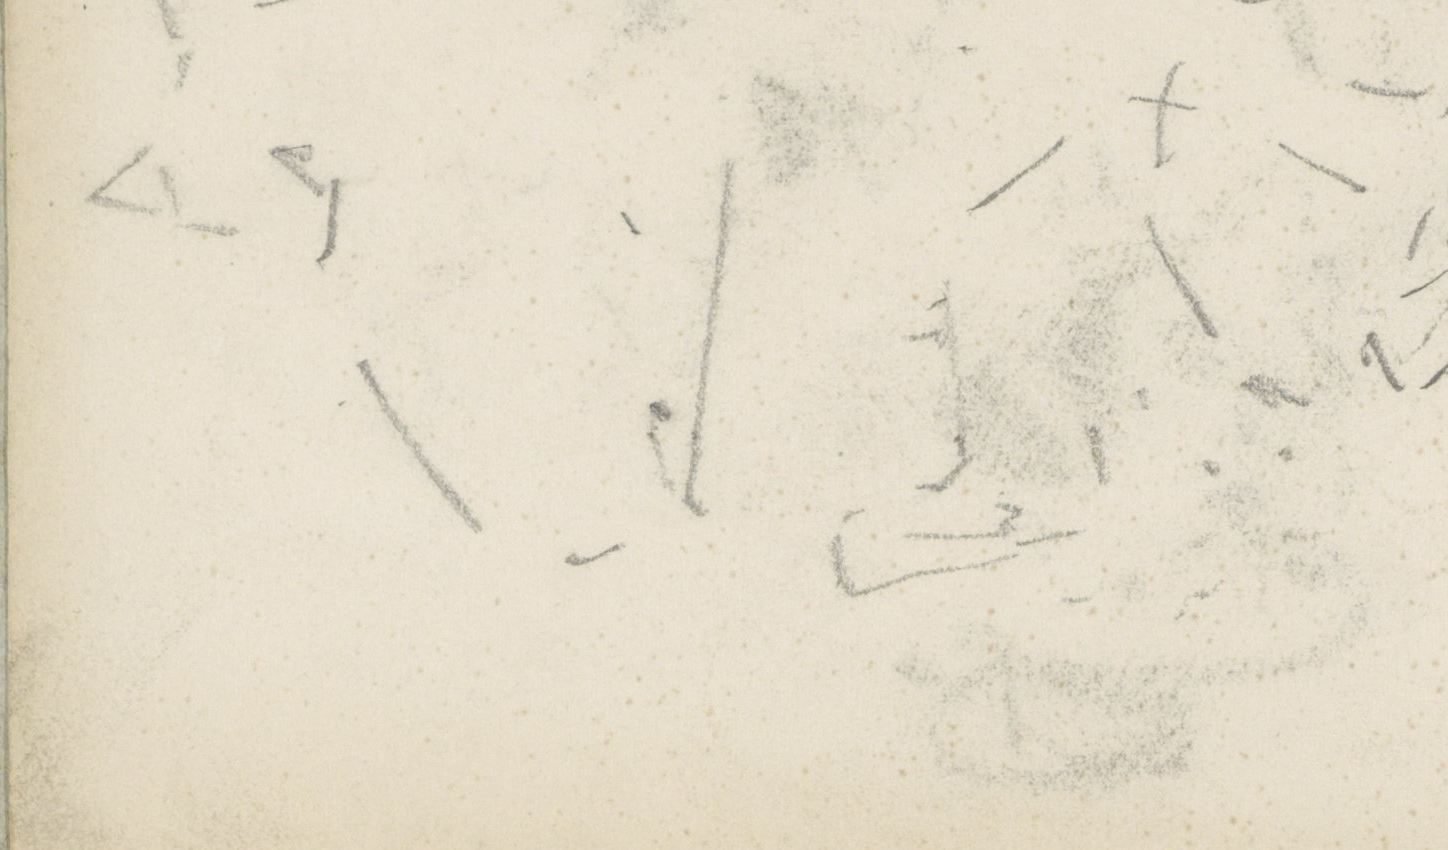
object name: sketchbook leaf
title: Studieblad, mogelijk met katten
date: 1881-1883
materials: paper, pencil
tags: cat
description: Pagina 3 uit een schetsboek met 30 bladen.